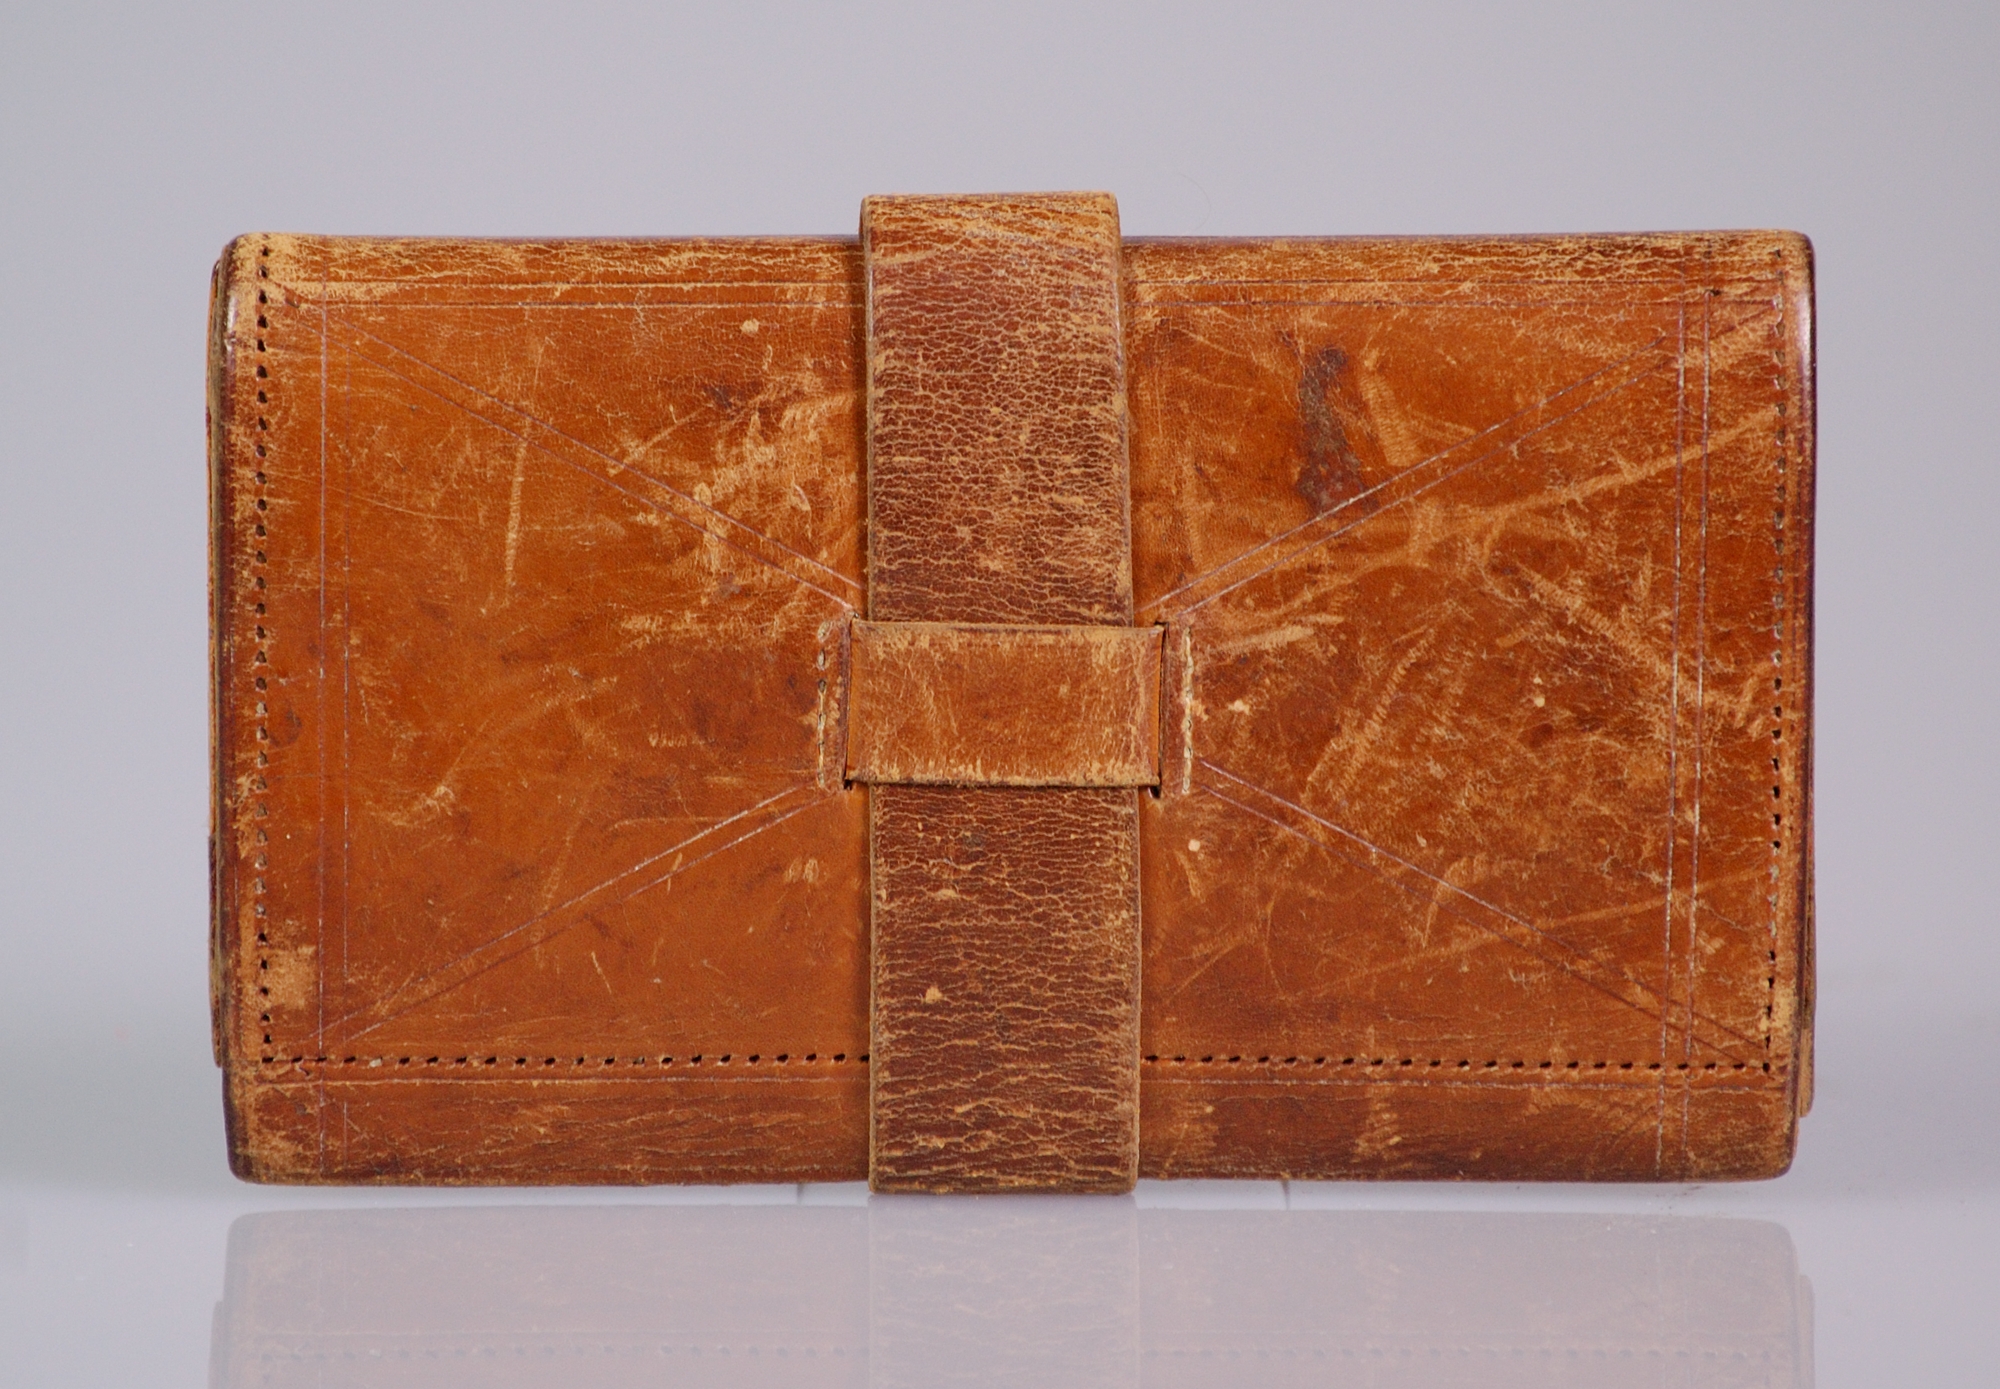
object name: wallet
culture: american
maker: chas. arms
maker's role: maker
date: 1840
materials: leather